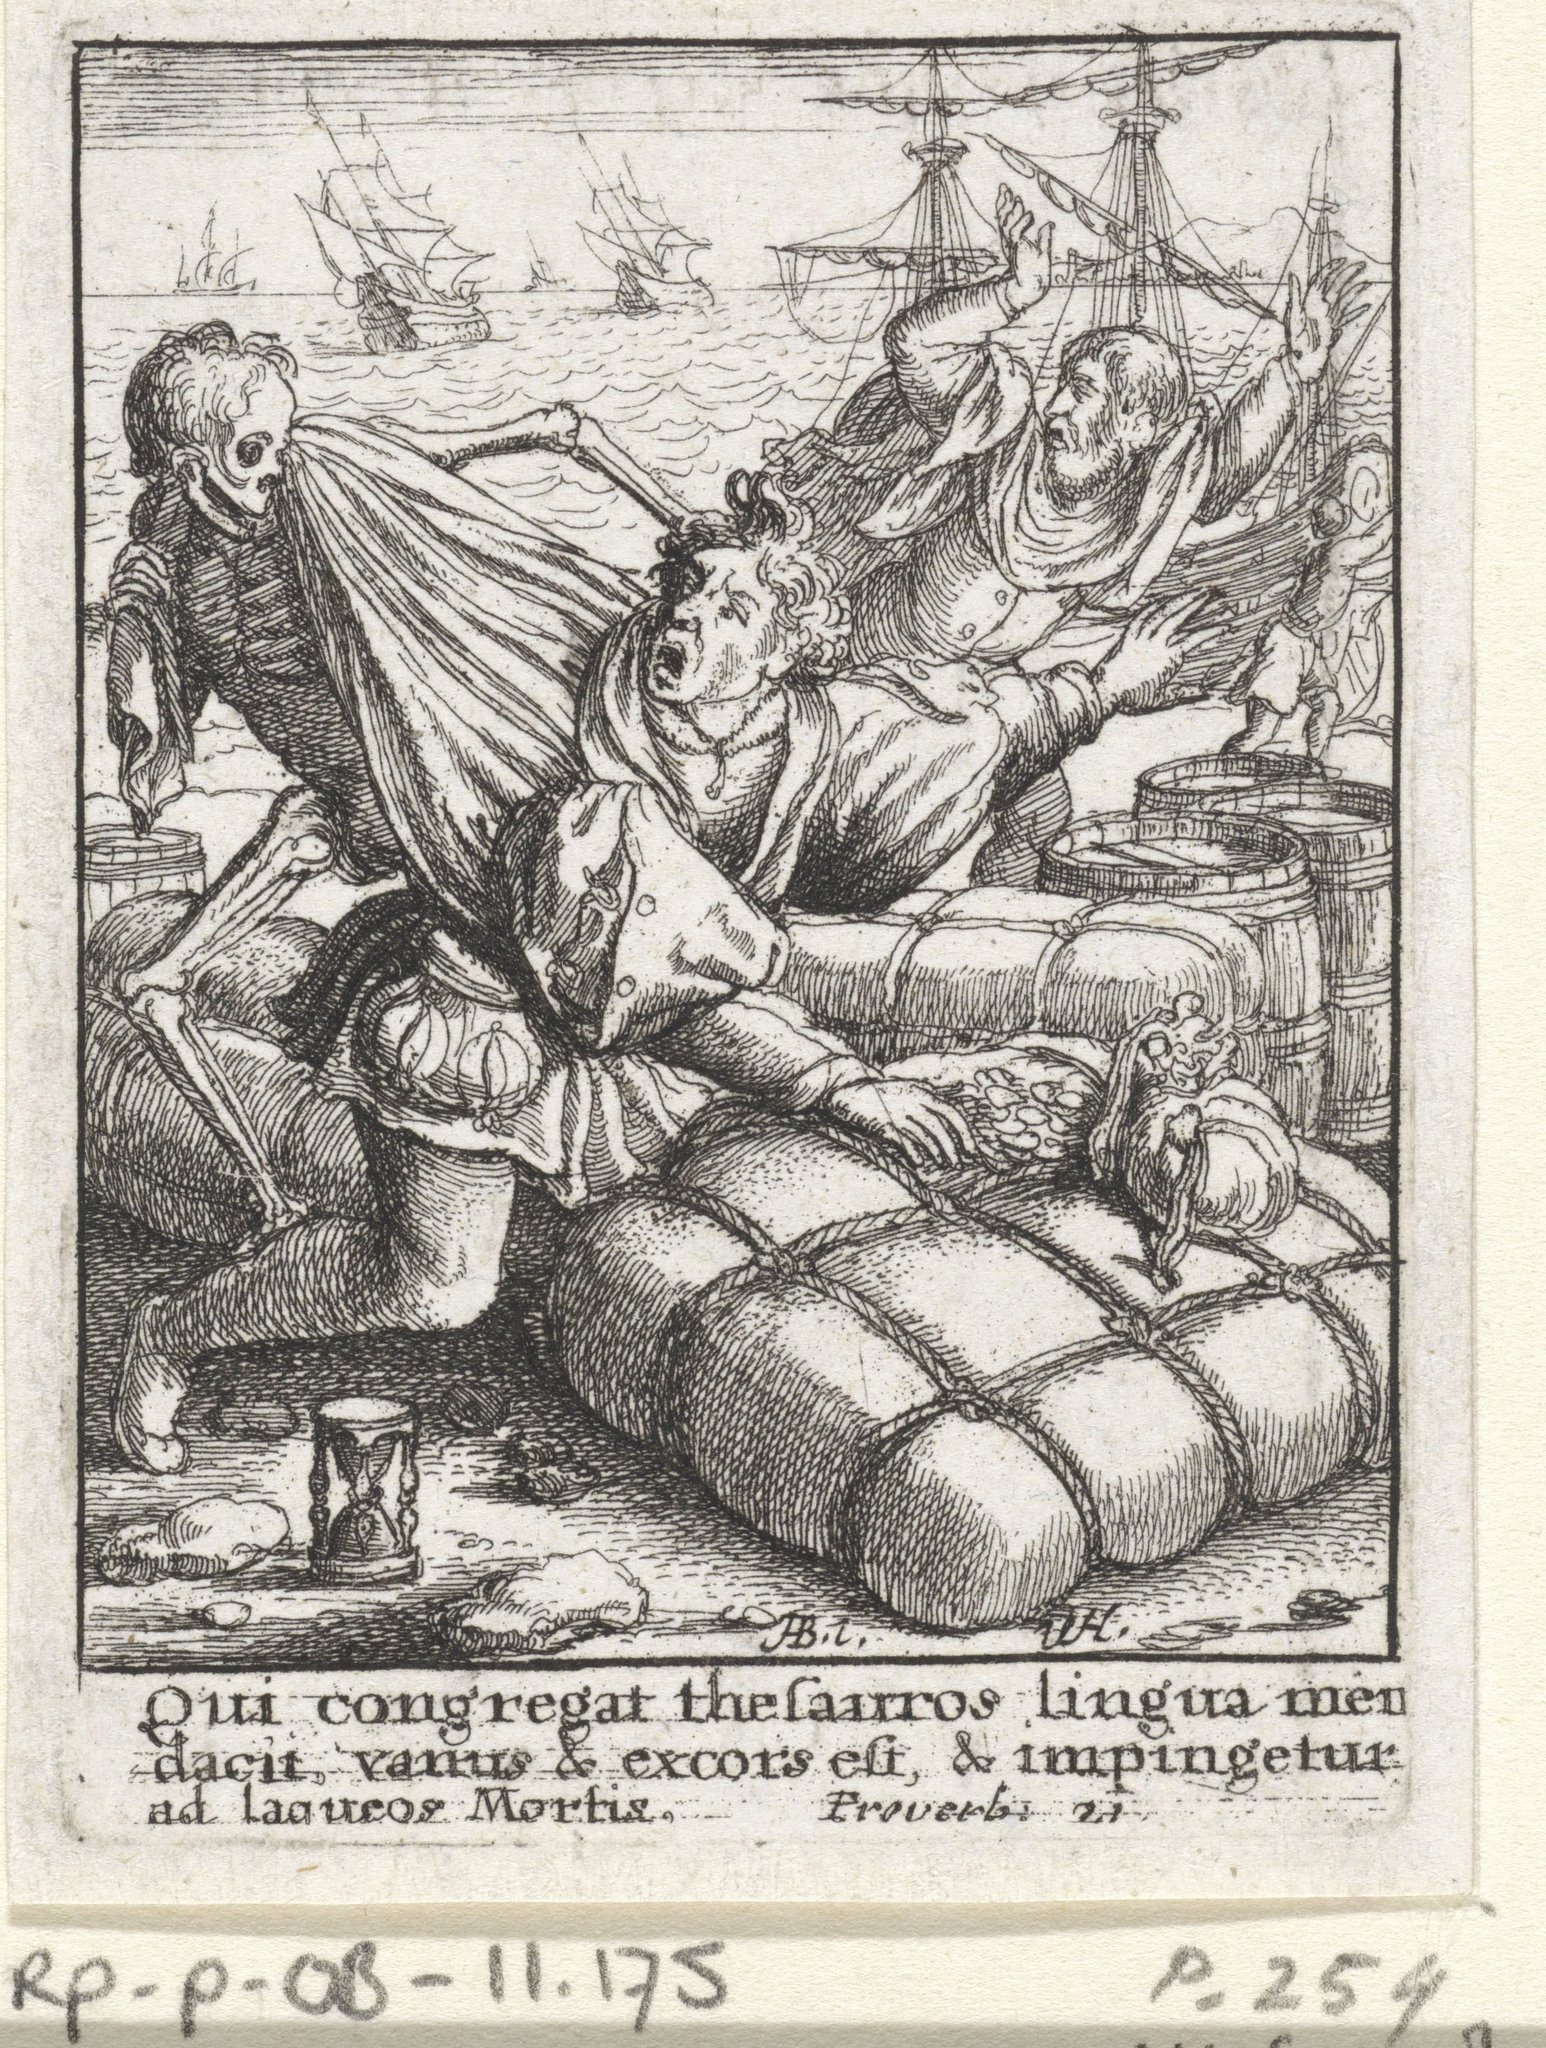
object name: print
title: De koopman en de Dood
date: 1680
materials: paper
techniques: etching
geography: antwerp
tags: dance of death; death together with one or more human beings, hourglass, merchant, salesman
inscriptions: collector's mark: Lugt 240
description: Een koopman telt bij de haven zijn geld op een bundel koopwaar. De Dood trekt hem aan zijn jas. Op de voorgrond staat een zandloper.